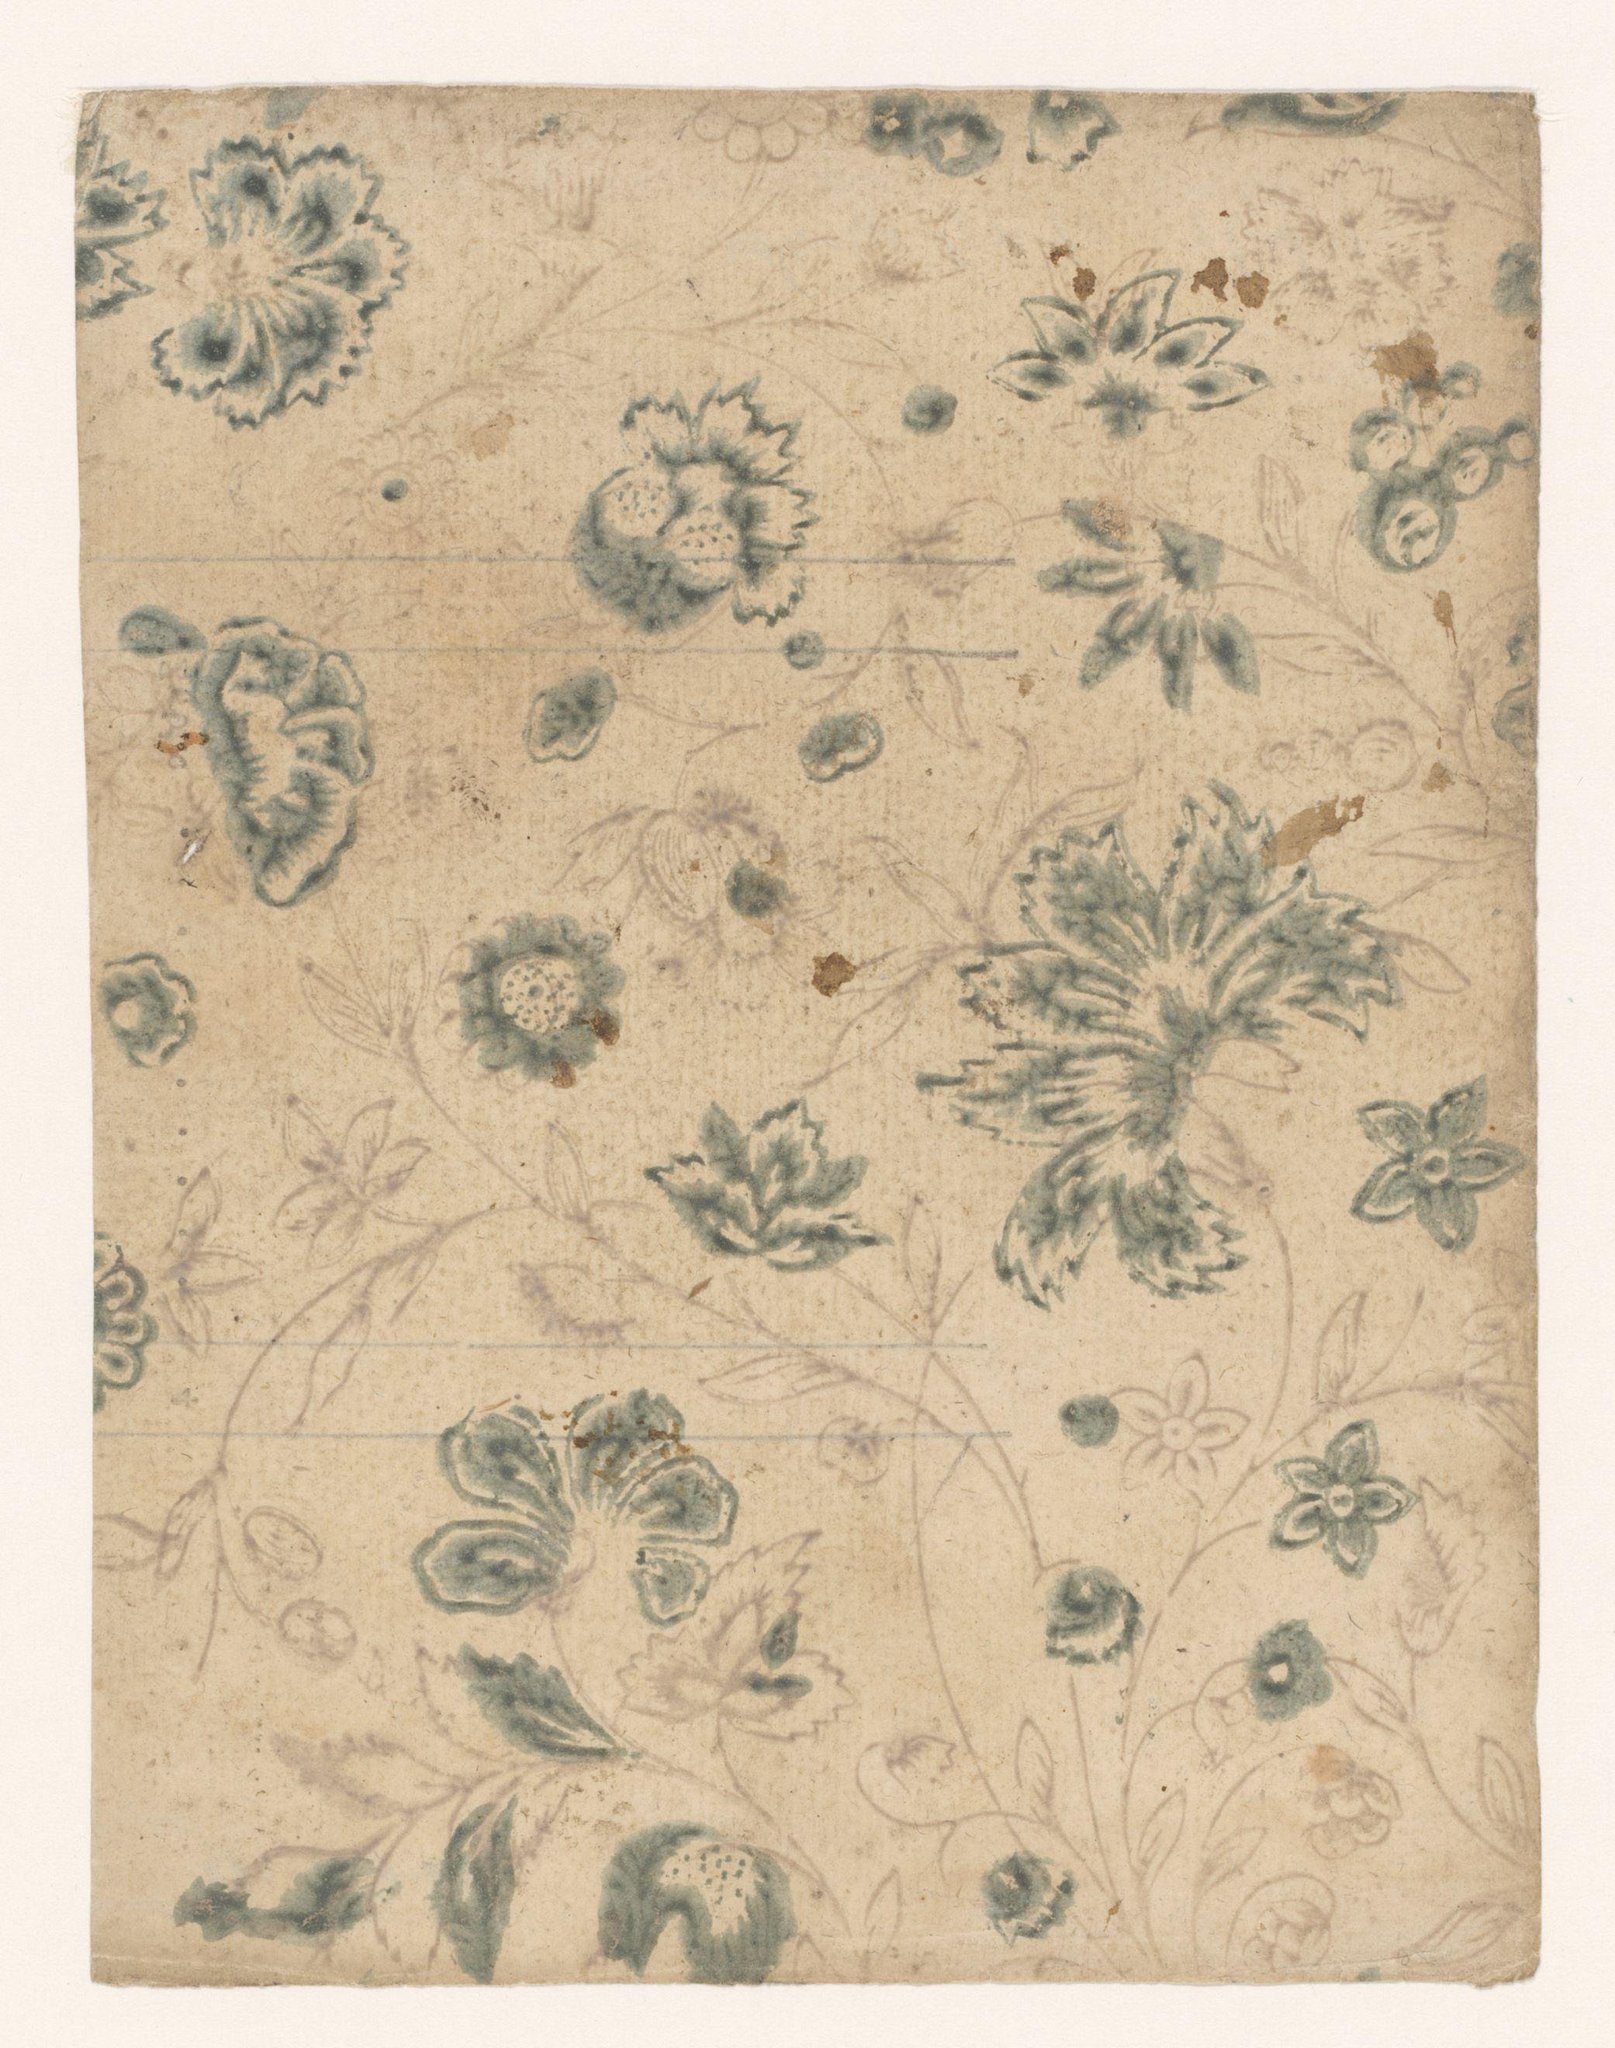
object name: printed paper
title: Blad met ranken met bloemen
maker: Anonymous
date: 1700-1850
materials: paper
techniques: printing block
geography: netherlands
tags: ornament derived from plant forms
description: Blad met ranken met bloemen. Op de achterkant gedrukt 'Zwolle ... 4'.